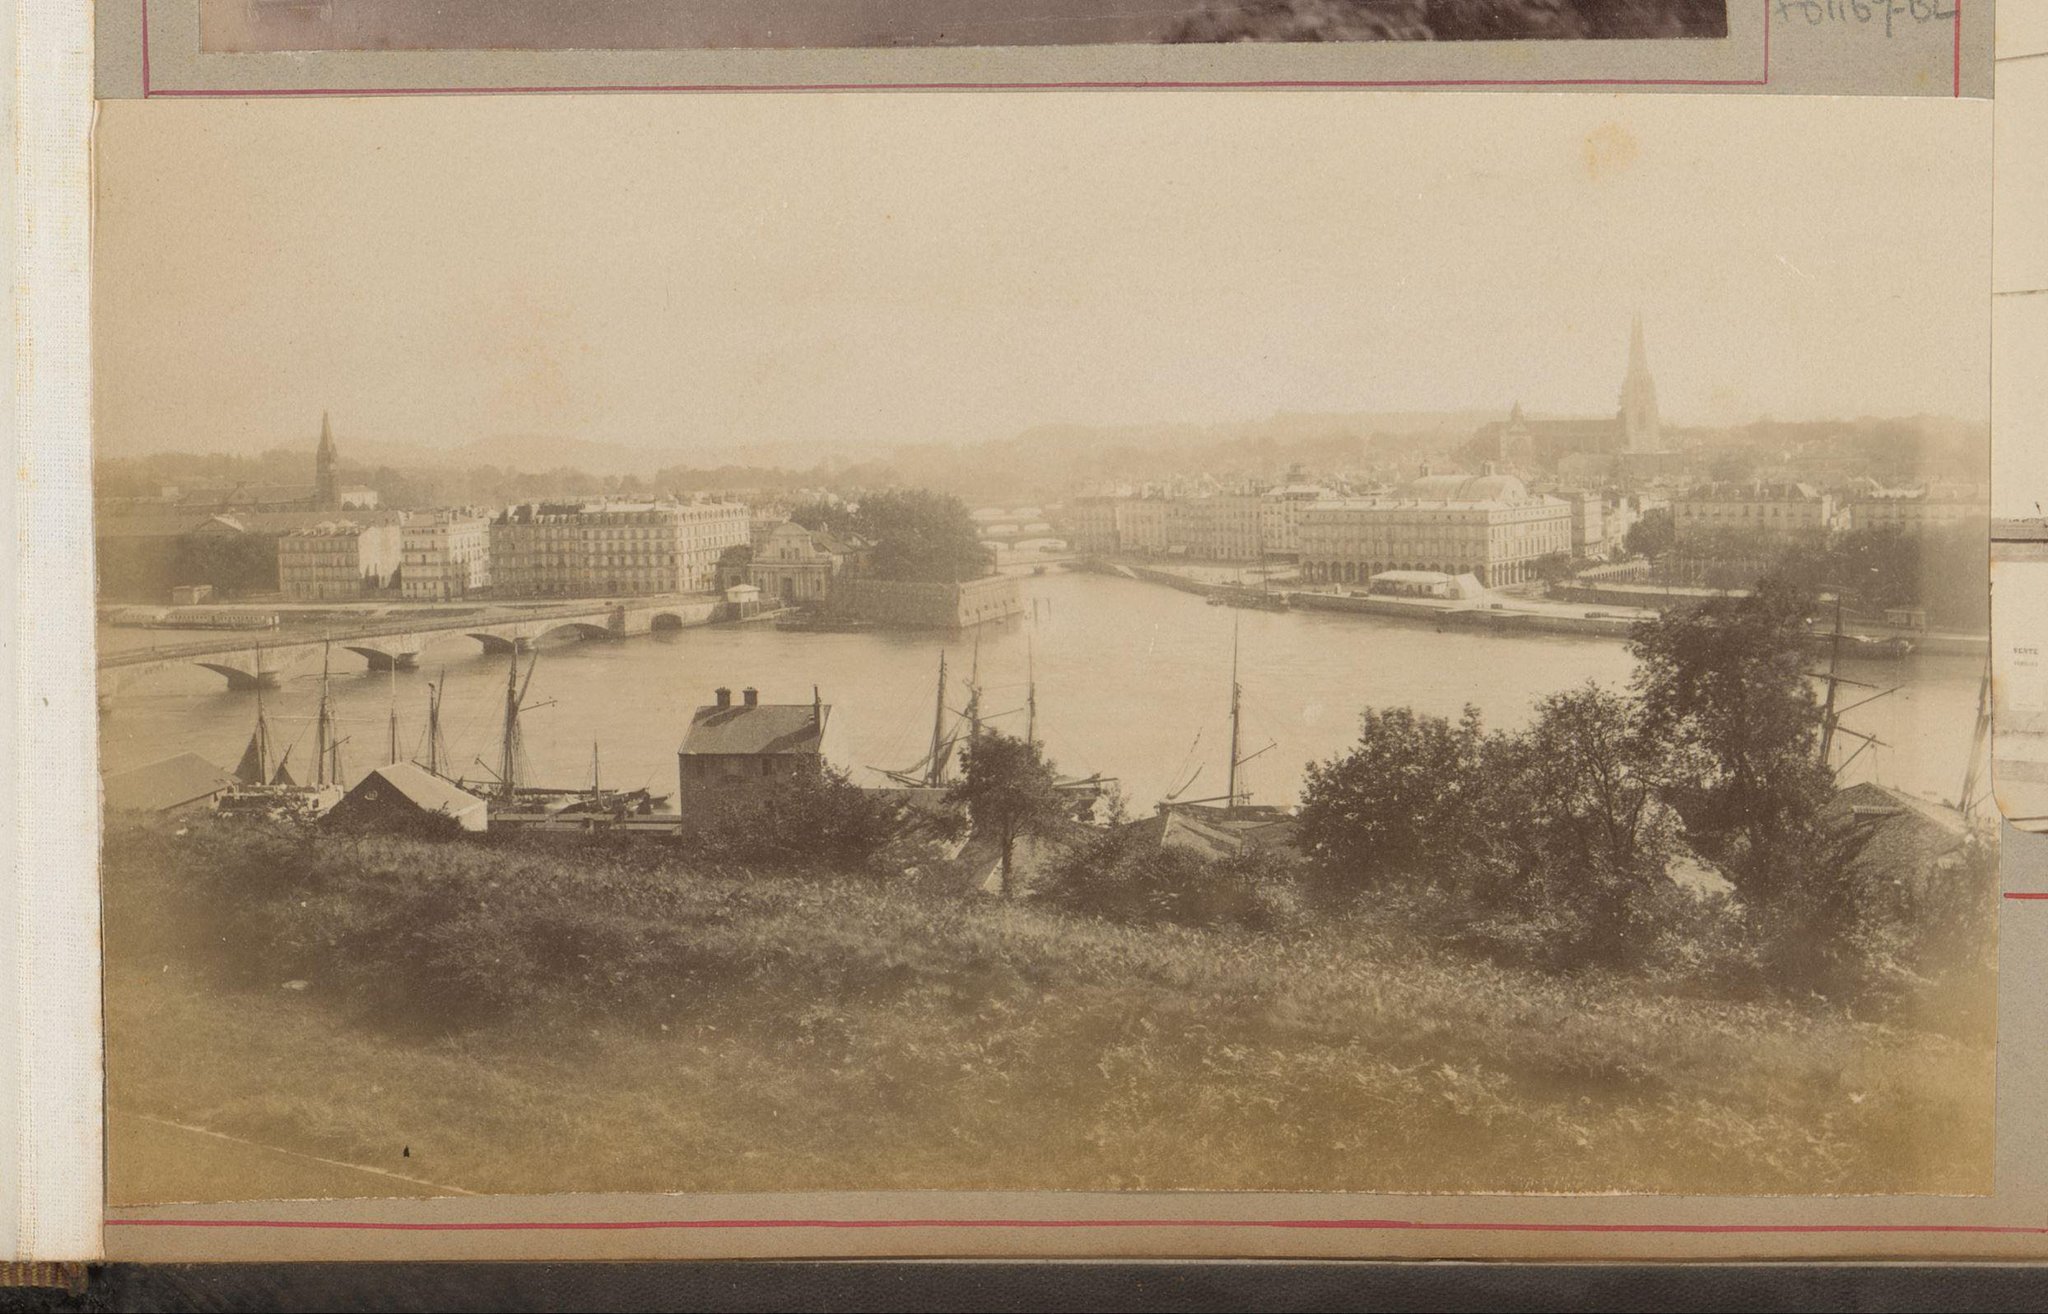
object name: photograph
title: Gezicht op Bayonne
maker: Anonymous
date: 1880-1910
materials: photographic support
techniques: albumen print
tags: city-view in general; 'veduta', river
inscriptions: annotation: ‘Bayonne/ [...]’